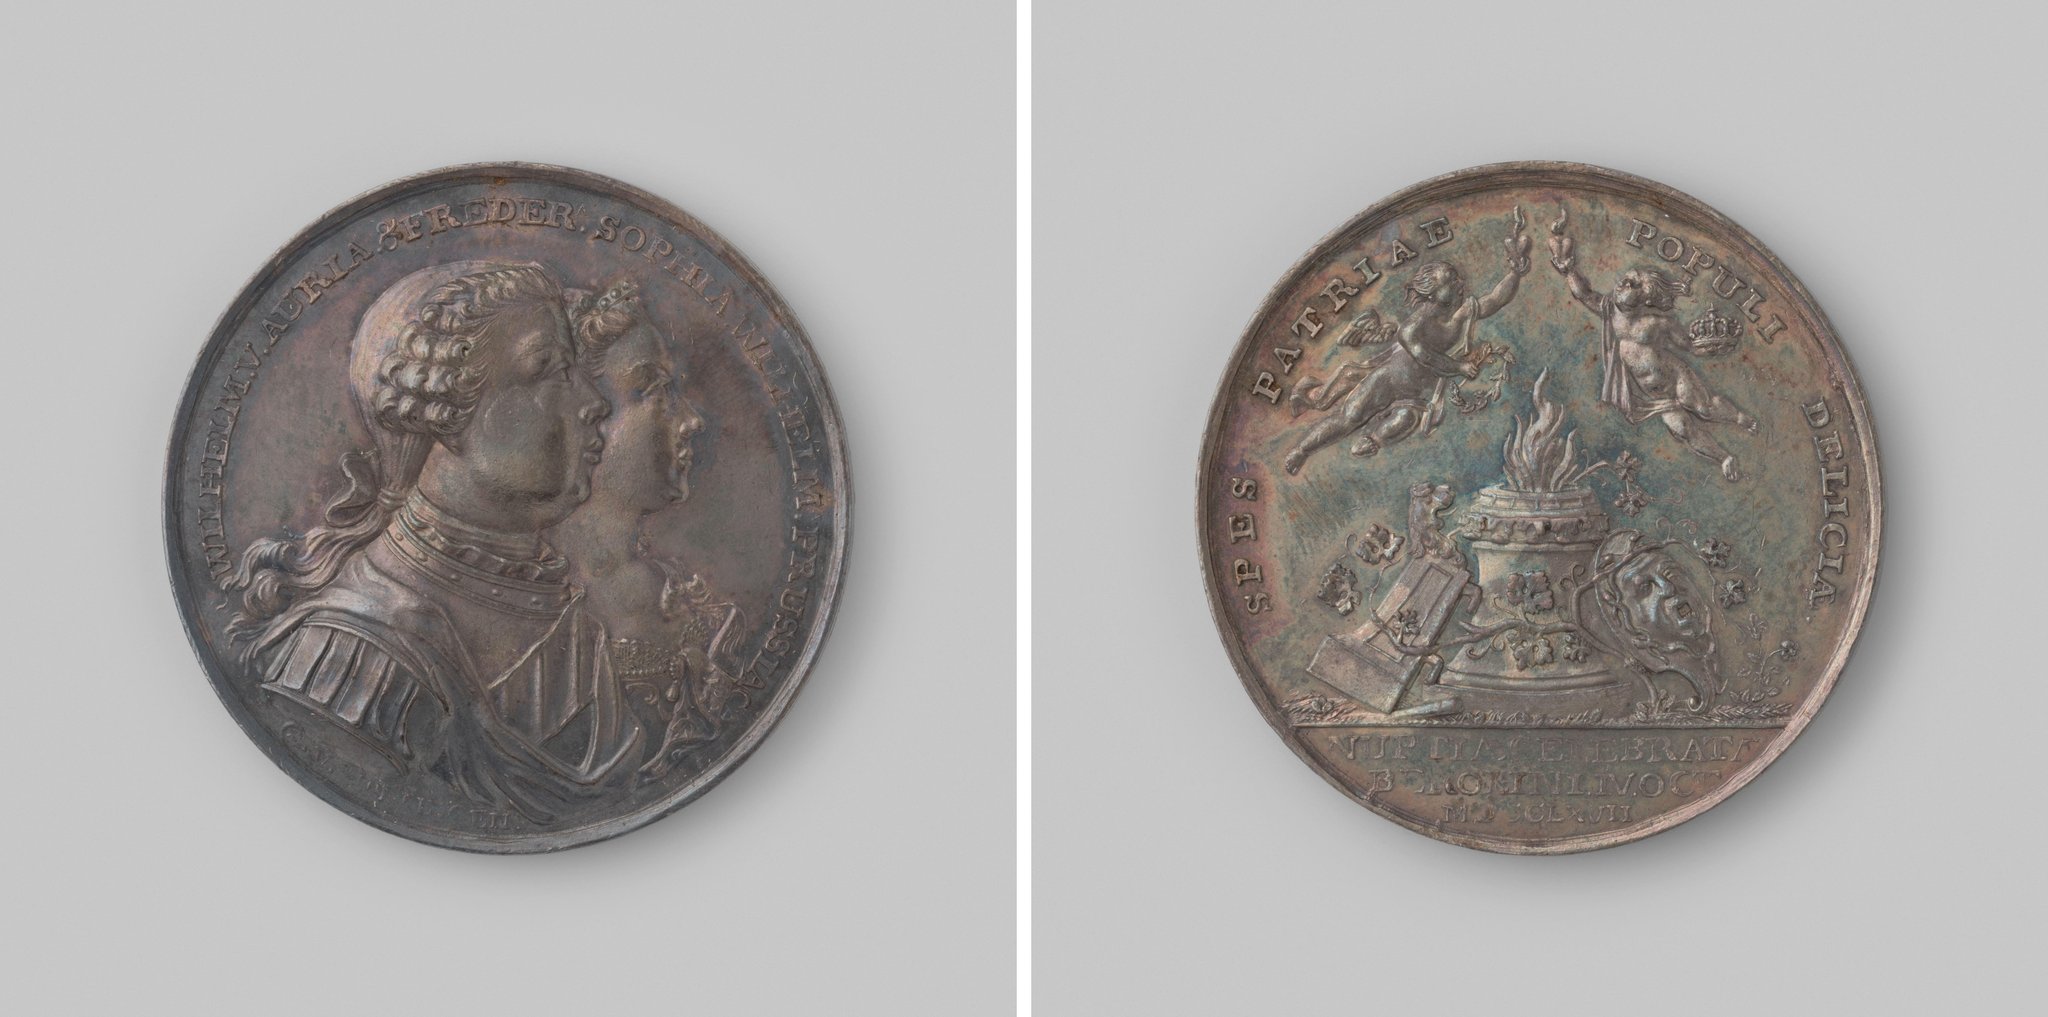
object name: history medal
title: Op het voltrokken huwelijk van Prins Willem V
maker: gijsbert van moelingen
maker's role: medailleur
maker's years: 1731-1789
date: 1767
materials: silver